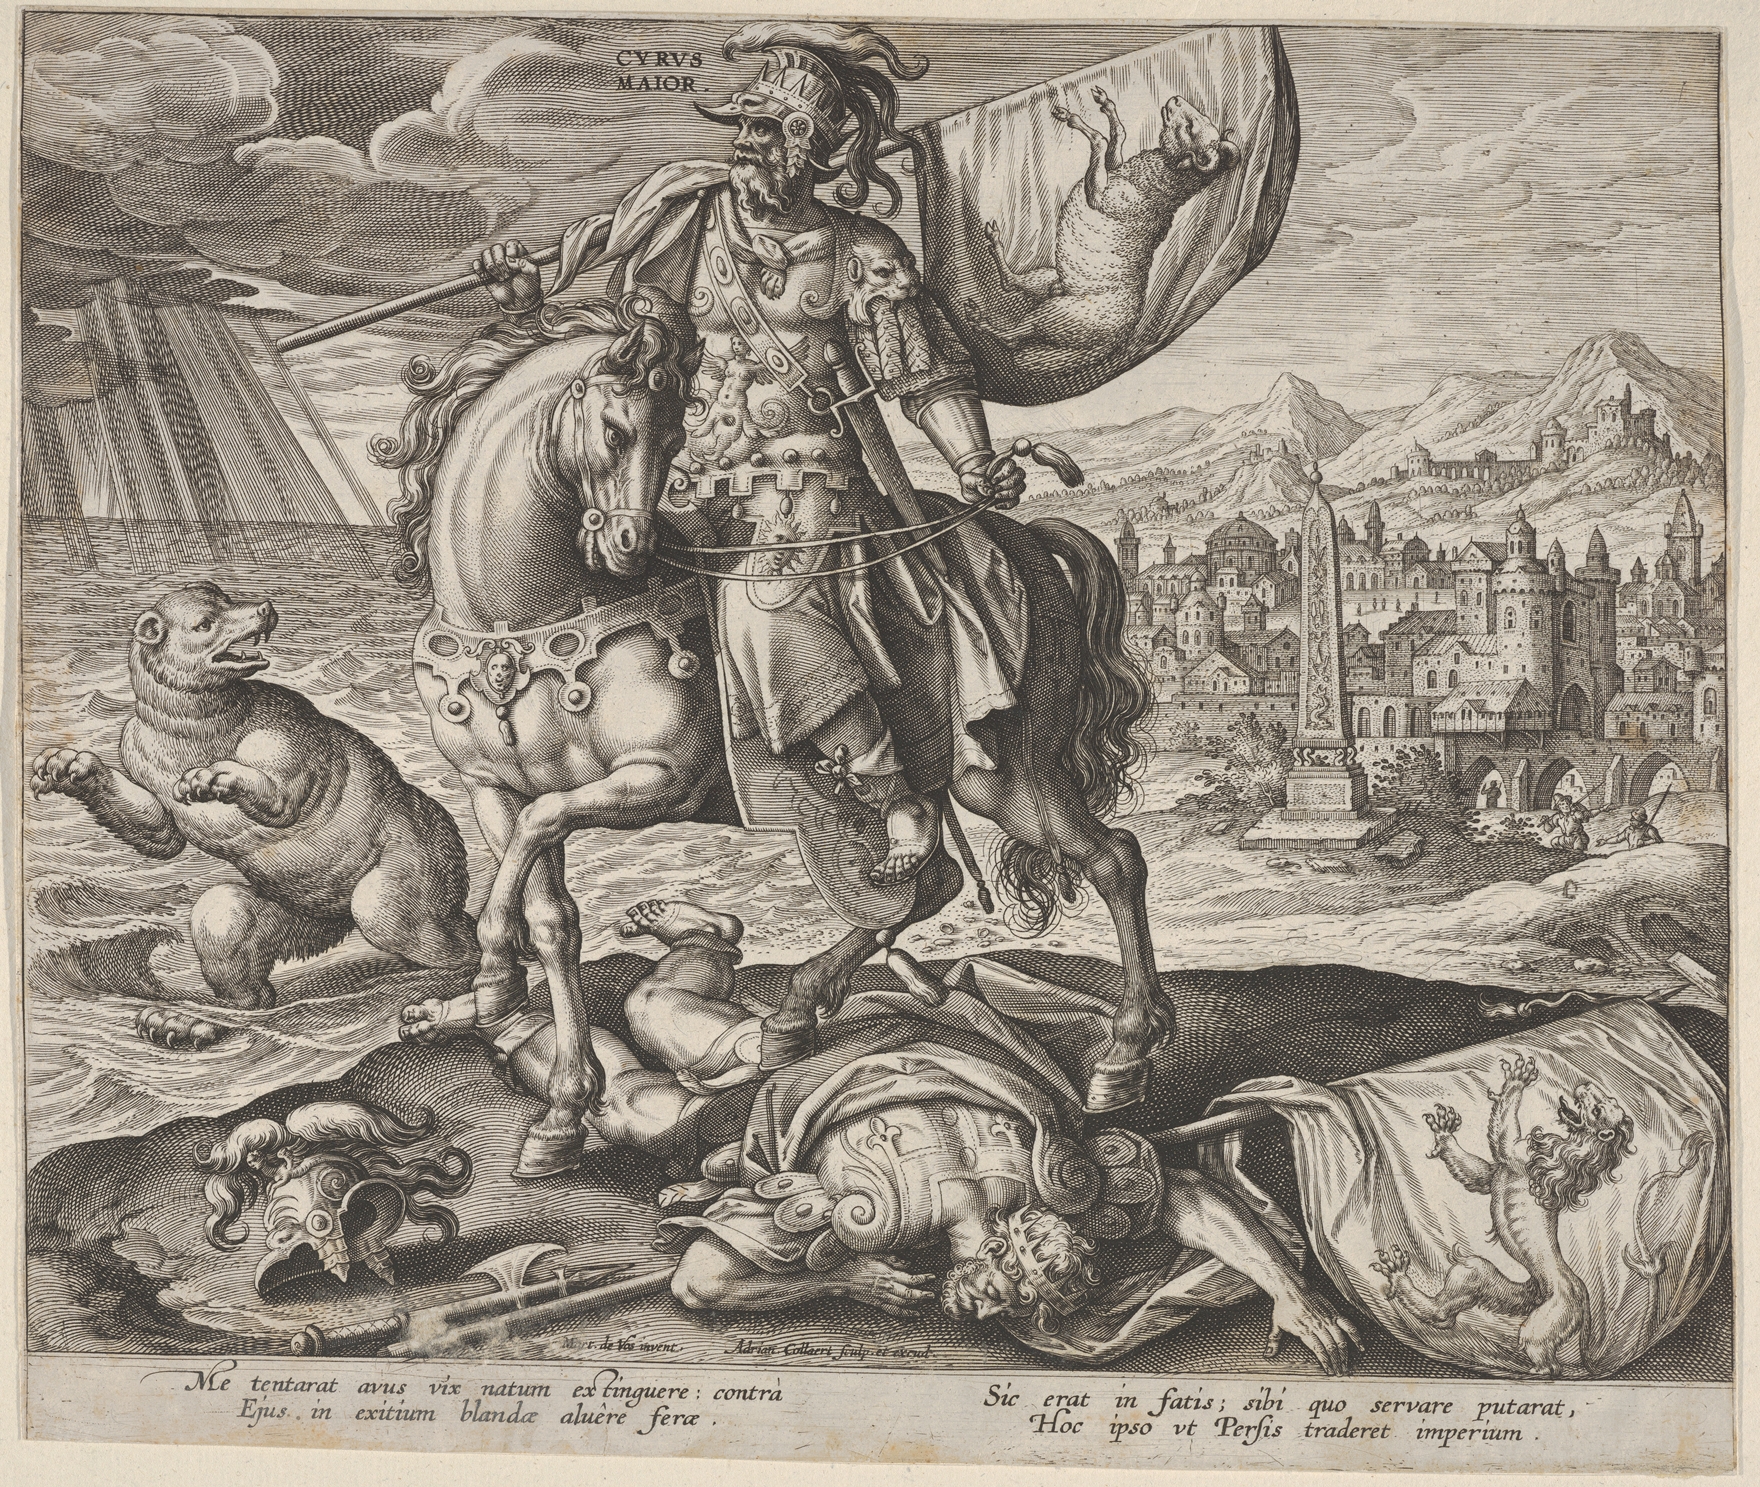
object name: print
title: Cyrus, King of Persia, from "Four Illustrious Rulers of Antiquity"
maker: adriaen collaert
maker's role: artist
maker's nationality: netherlandish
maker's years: 1560-1618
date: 1590-1599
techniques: engraving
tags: kings,corpses,horses,flags